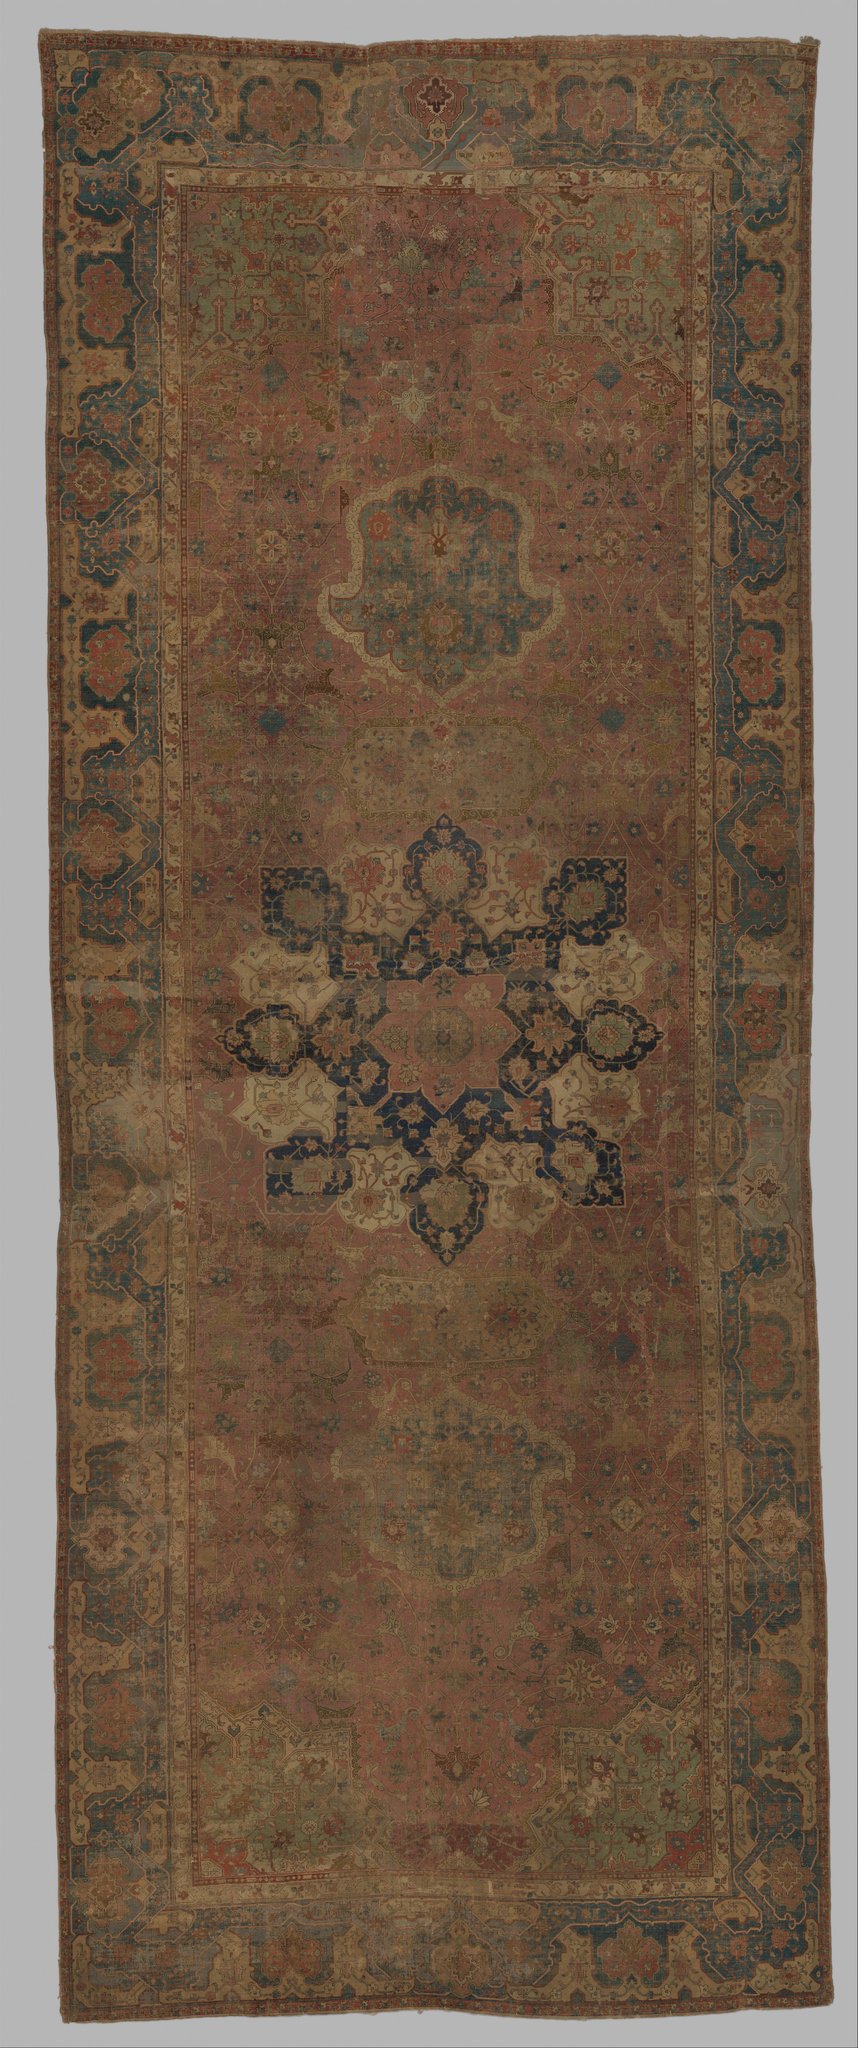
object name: carpet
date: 1501-1600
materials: cotton, wool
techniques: asymmetrically knotted pile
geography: iran